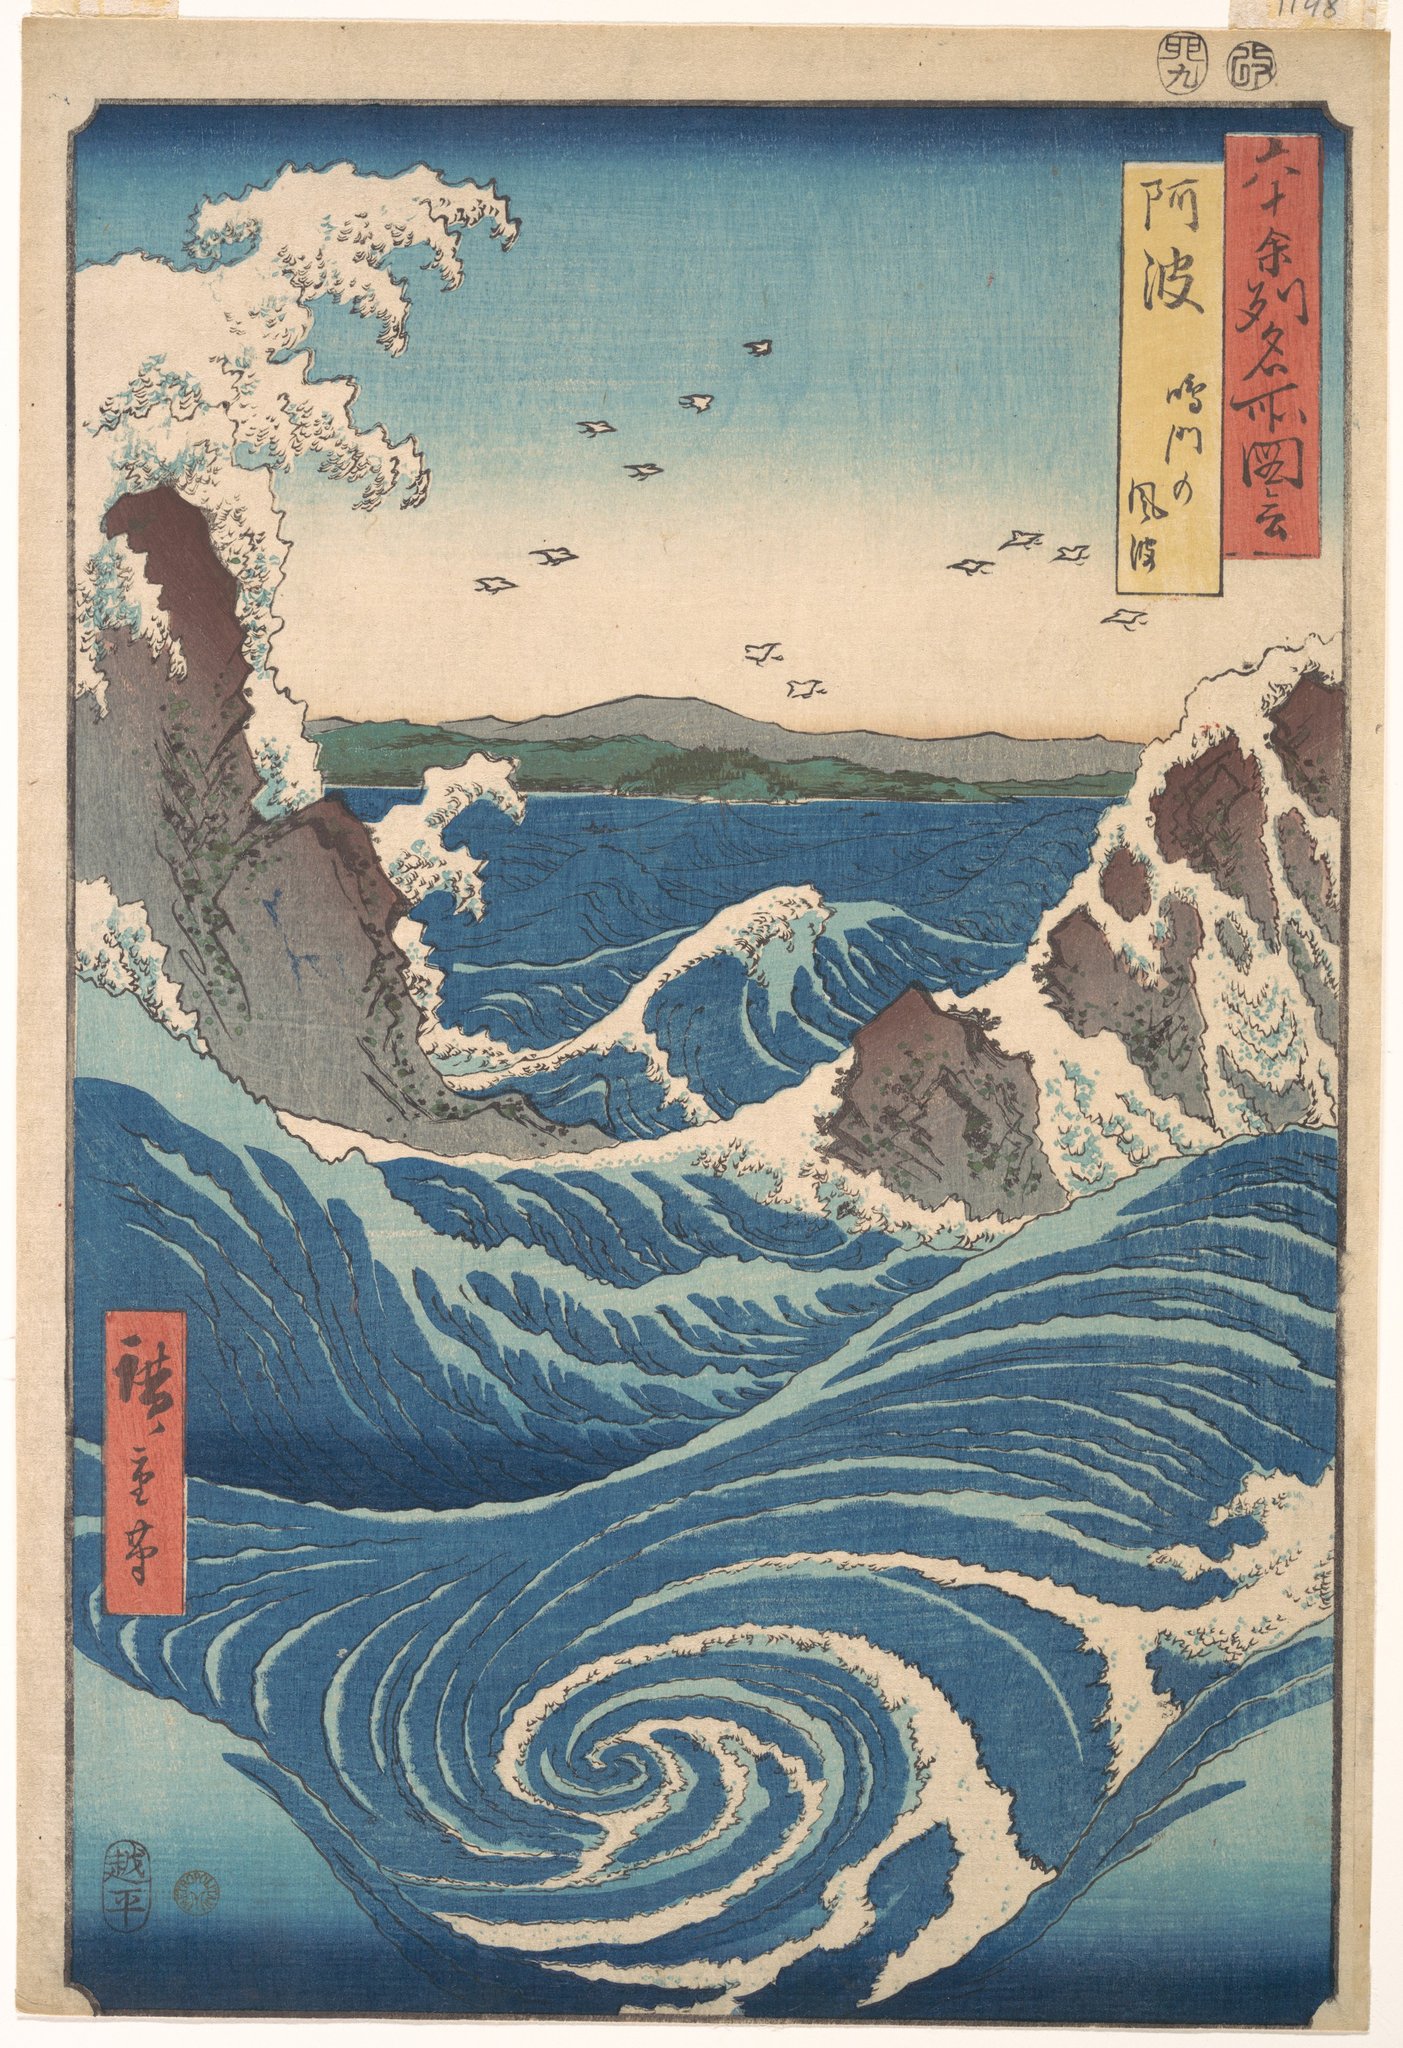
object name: print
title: Naruto Whirlpool, Awa Province, from the series Views of Famous Places in the Sixty-Odd Provinces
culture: japanese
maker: utagawa hiroshige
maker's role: artist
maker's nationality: japanese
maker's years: 1797-1858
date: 1853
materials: ink, paper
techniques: woodblock print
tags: seascapes,waves